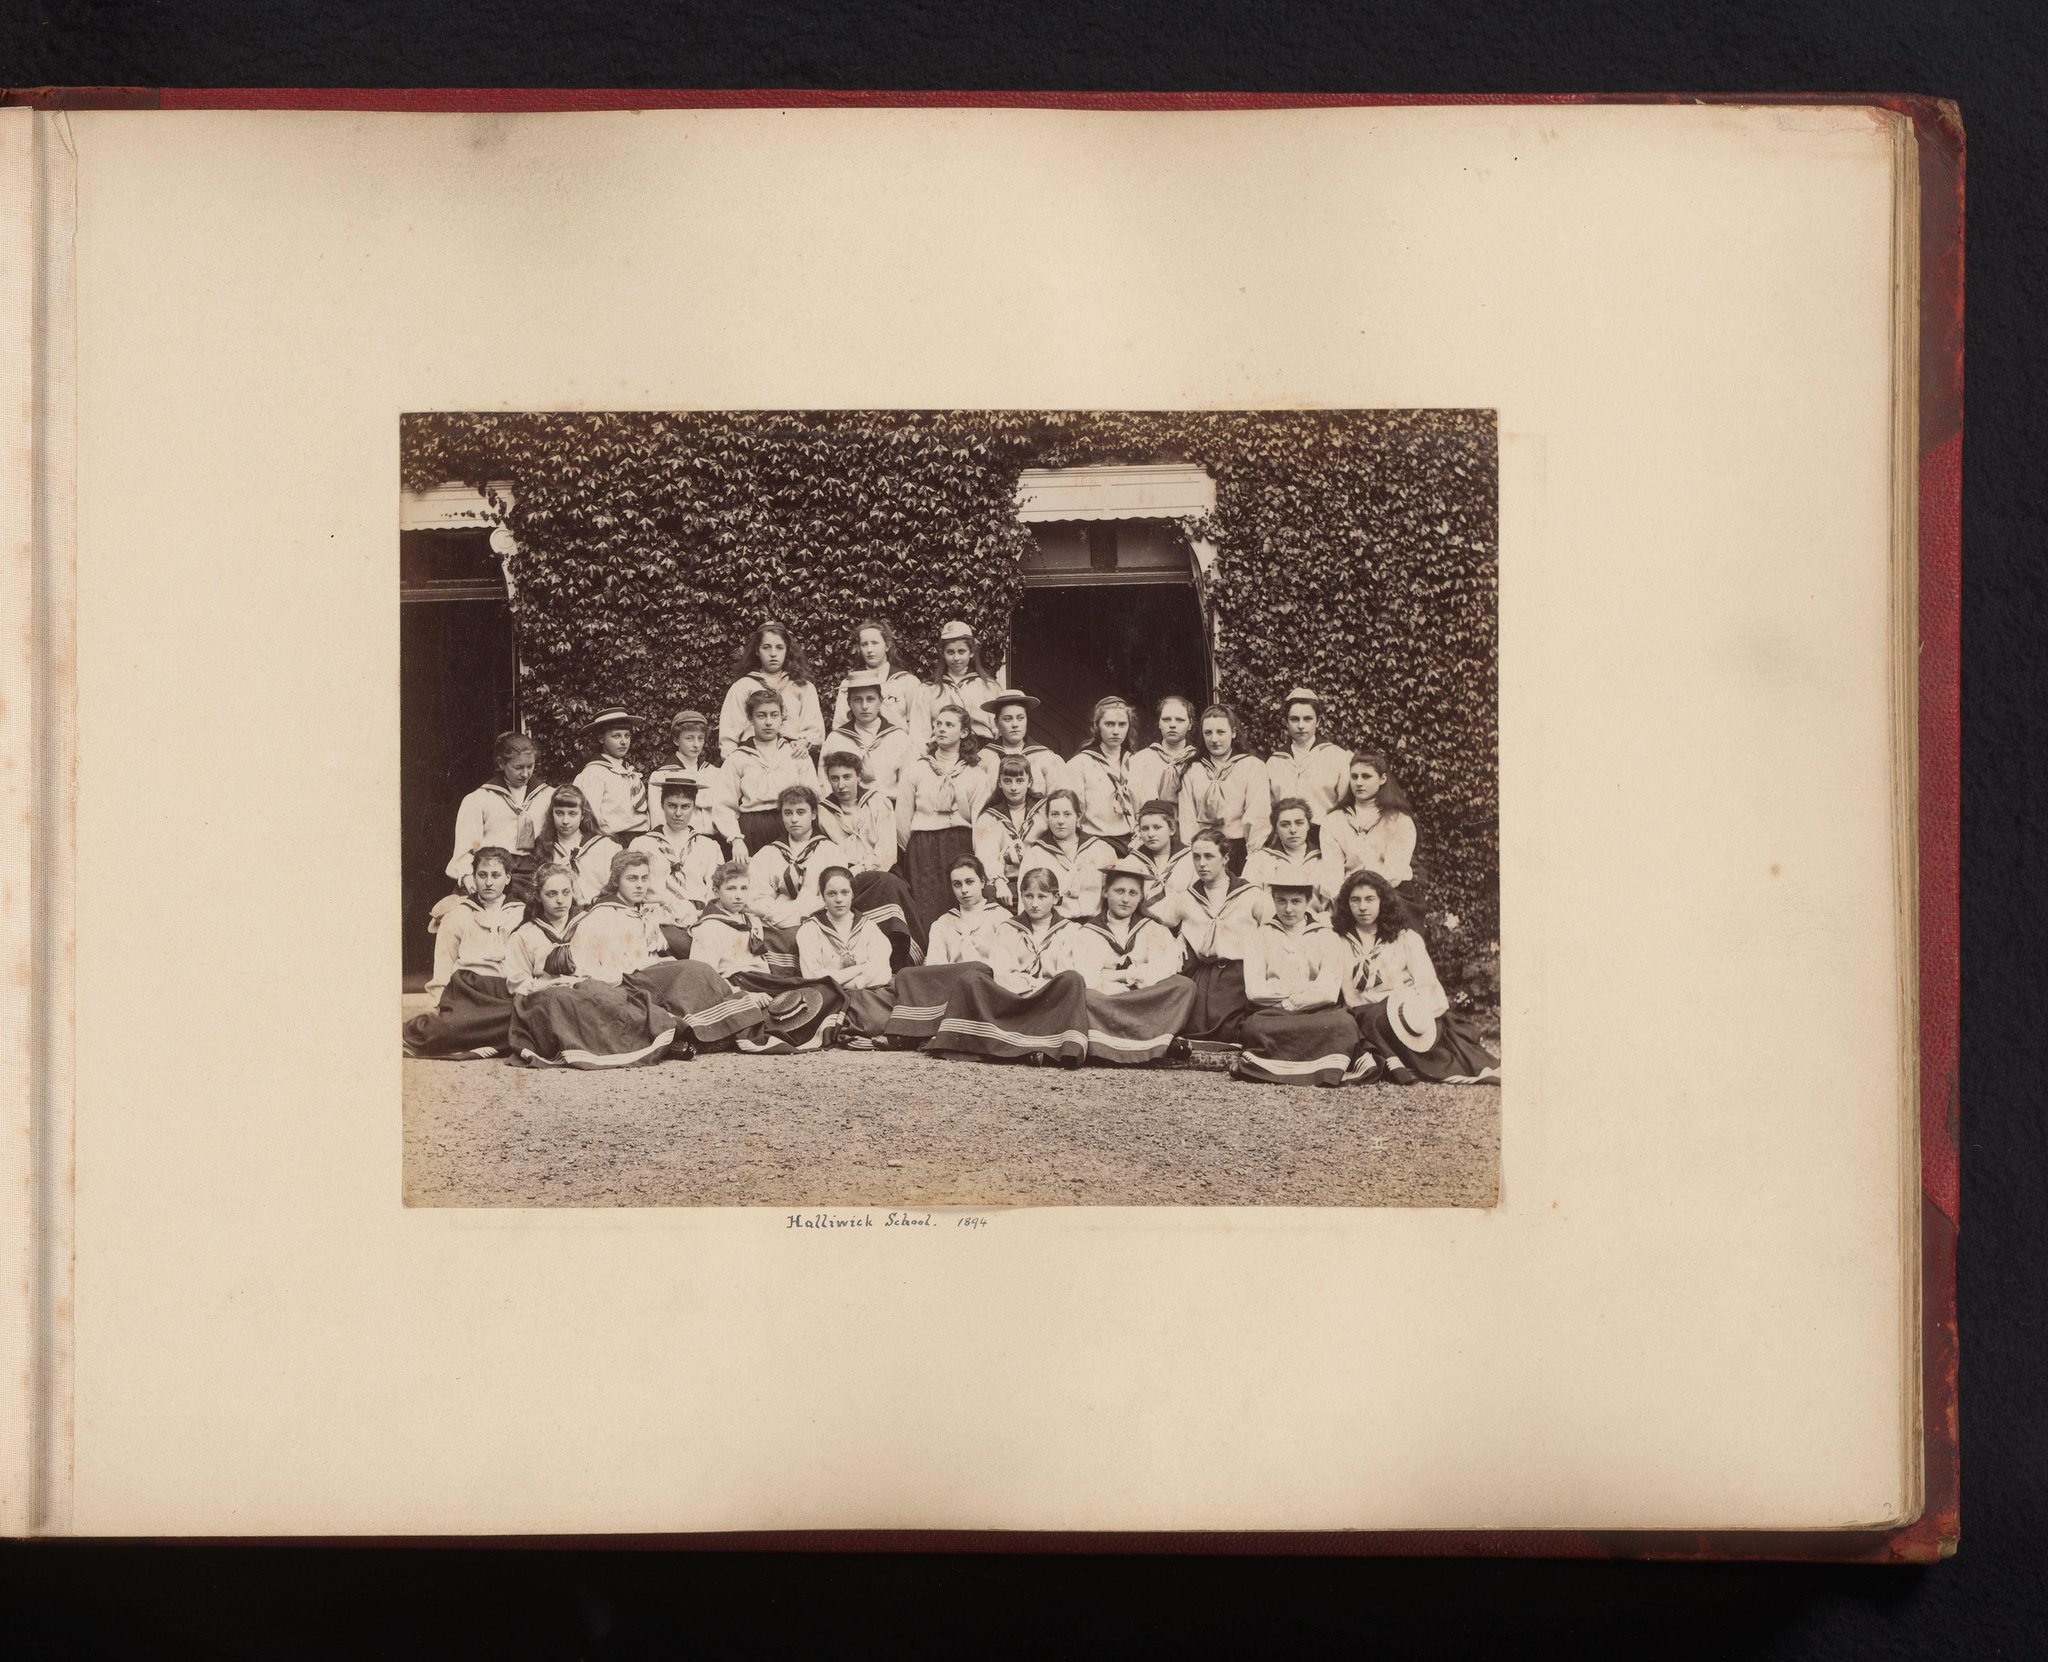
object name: photograph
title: Groepsportret met leerlingen van de Halliwick School for Girls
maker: Anonymous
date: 1894-1896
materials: cardboard, photographic support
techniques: albumen print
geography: london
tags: anonymous historical persons portrayed in a group, in a group-portrait - bb - woman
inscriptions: annotation: ‘Halliwick School. 1894’